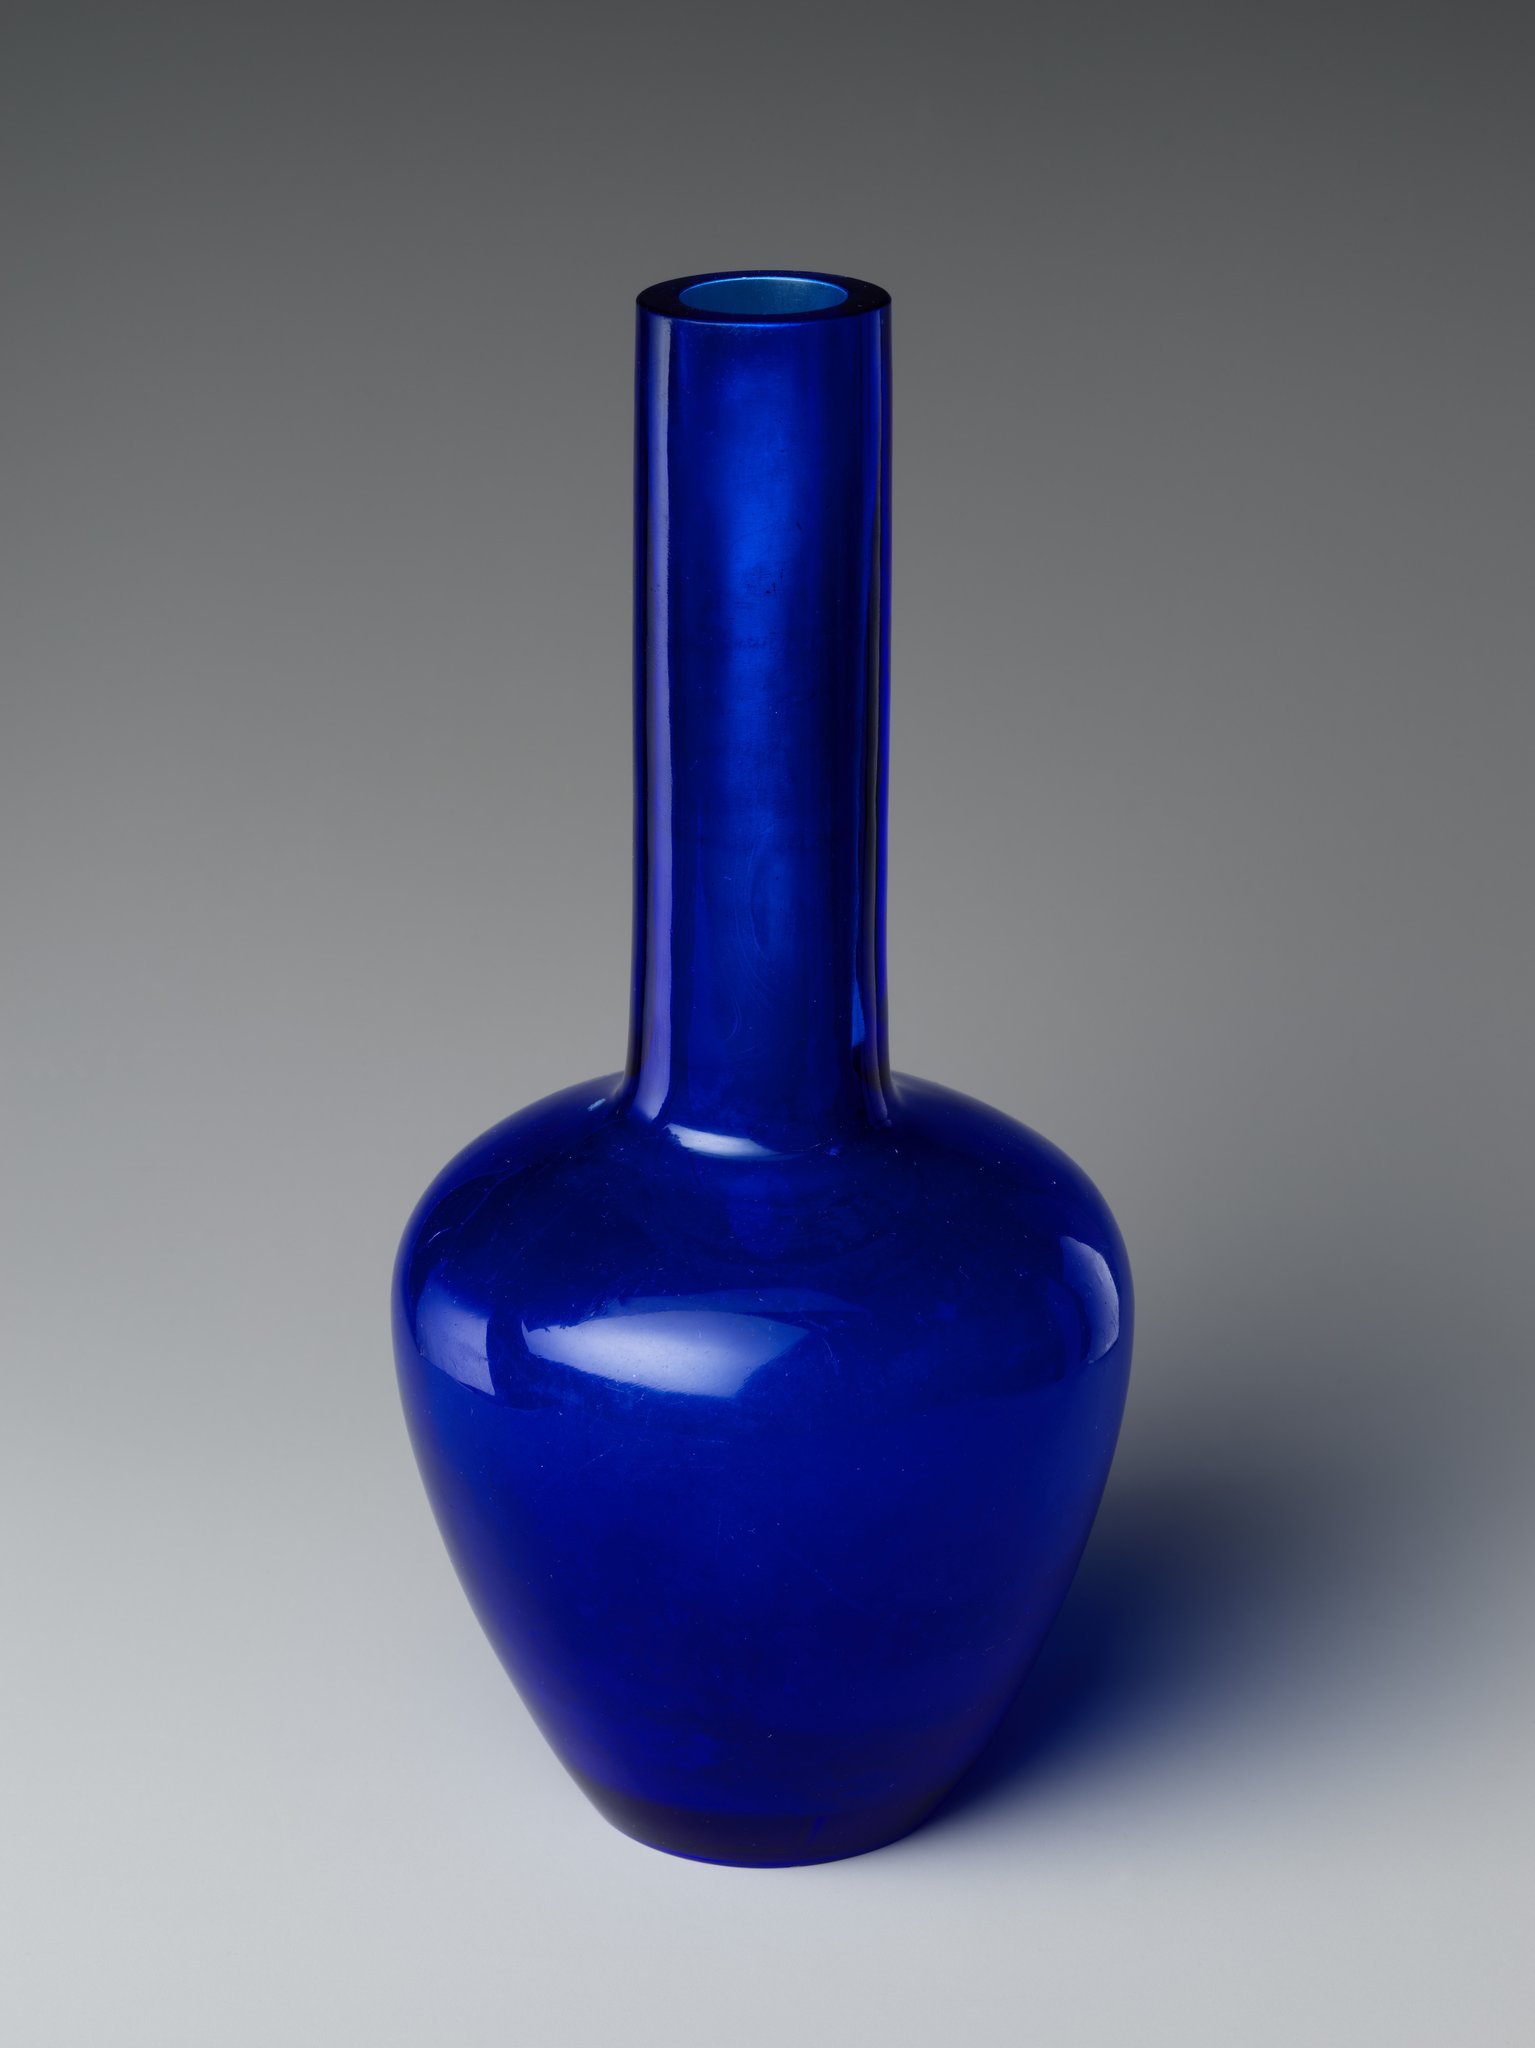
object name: vase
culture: chinese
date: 1751-1800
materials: glass